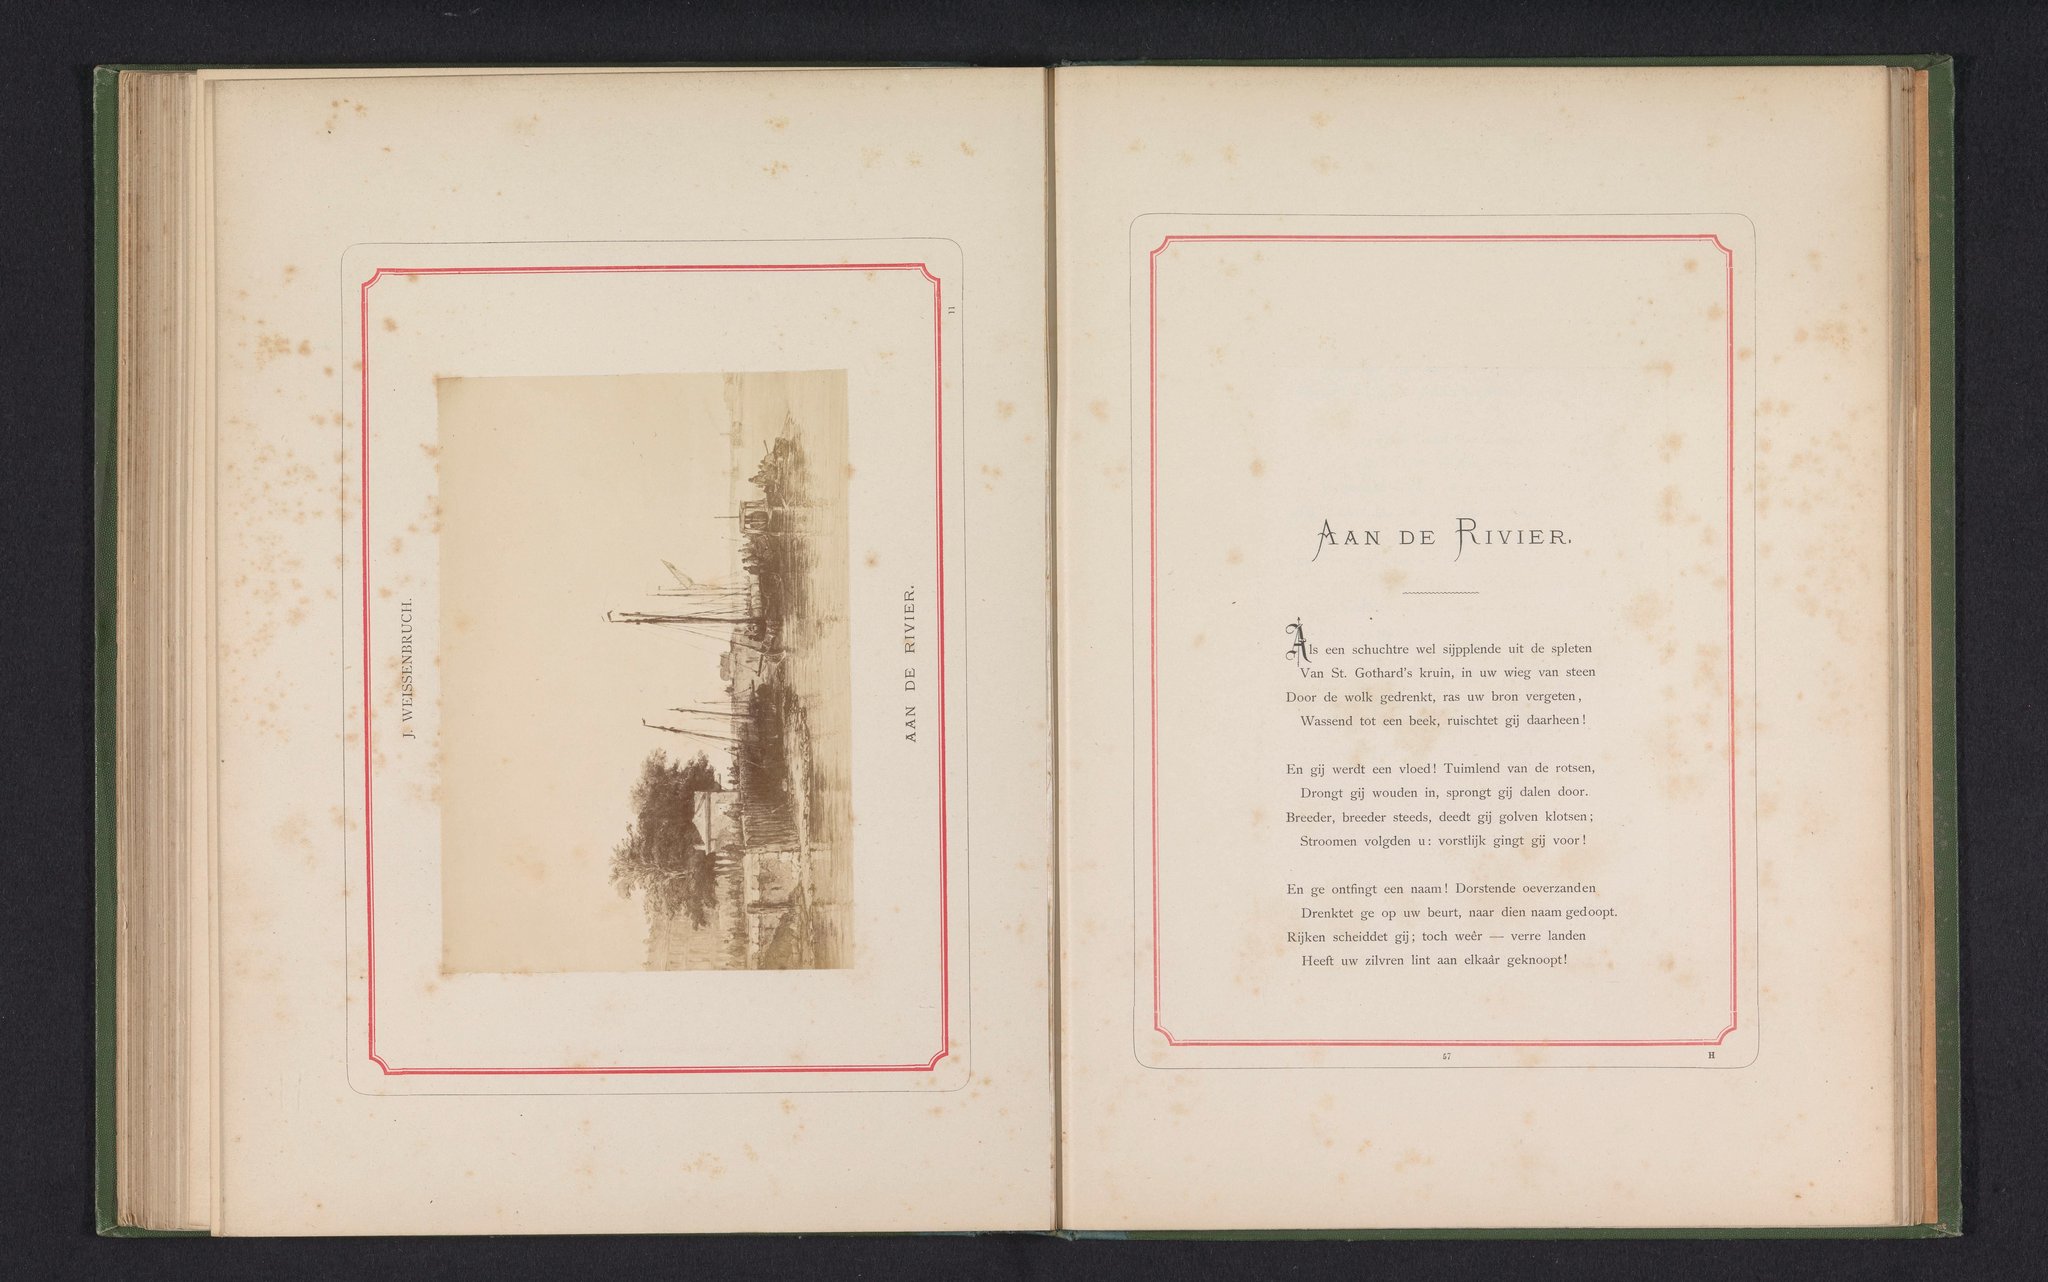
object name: reproduction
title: Aan de rivier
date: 1868-1878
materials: photographic support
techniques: albumen print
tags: river, ships (in general), pier, quay, wharf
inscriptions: number: ‘11’